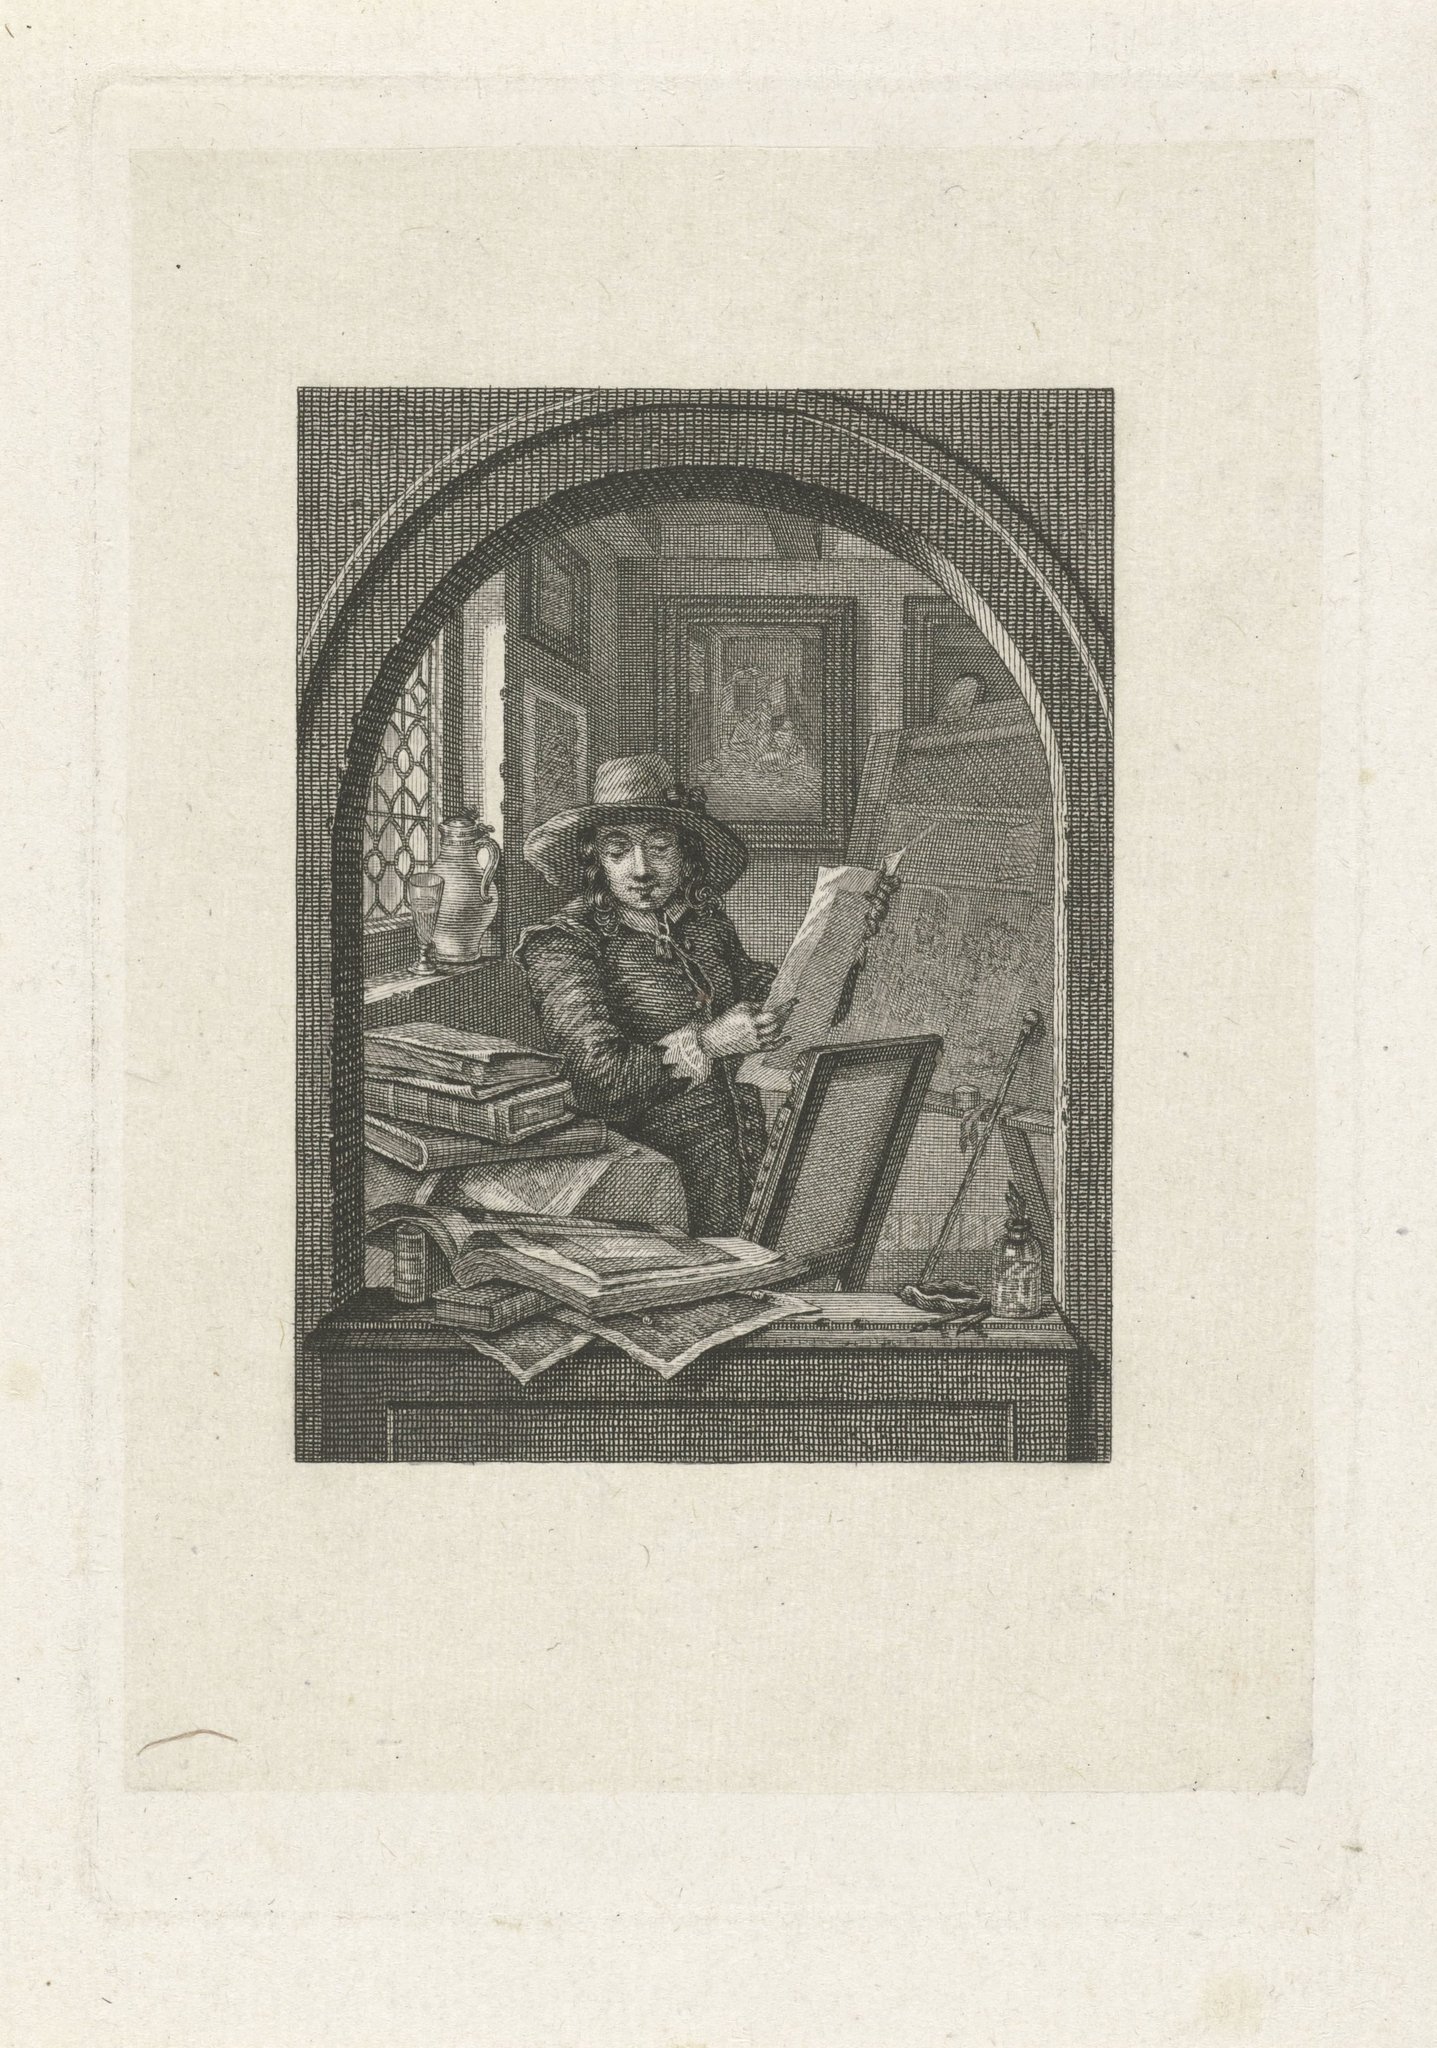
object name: print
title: Schilder in zijn atelier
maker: elisabeth barbara schmetterling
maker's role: draughtsman, print maker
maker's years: 1804-1882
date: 1814-1882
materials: paper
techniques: engraving, etching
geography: netherlands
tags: painter at work, in his studio, picture, painting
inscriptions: collector's mark: Lugt 2228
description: Een schilder in zijn atelier bij zijn schildersezel met in de hand en stuk papier, mogelijk een prent. In het atelier hangen schilderijen en in de raamopening liggen boeken en prenten.